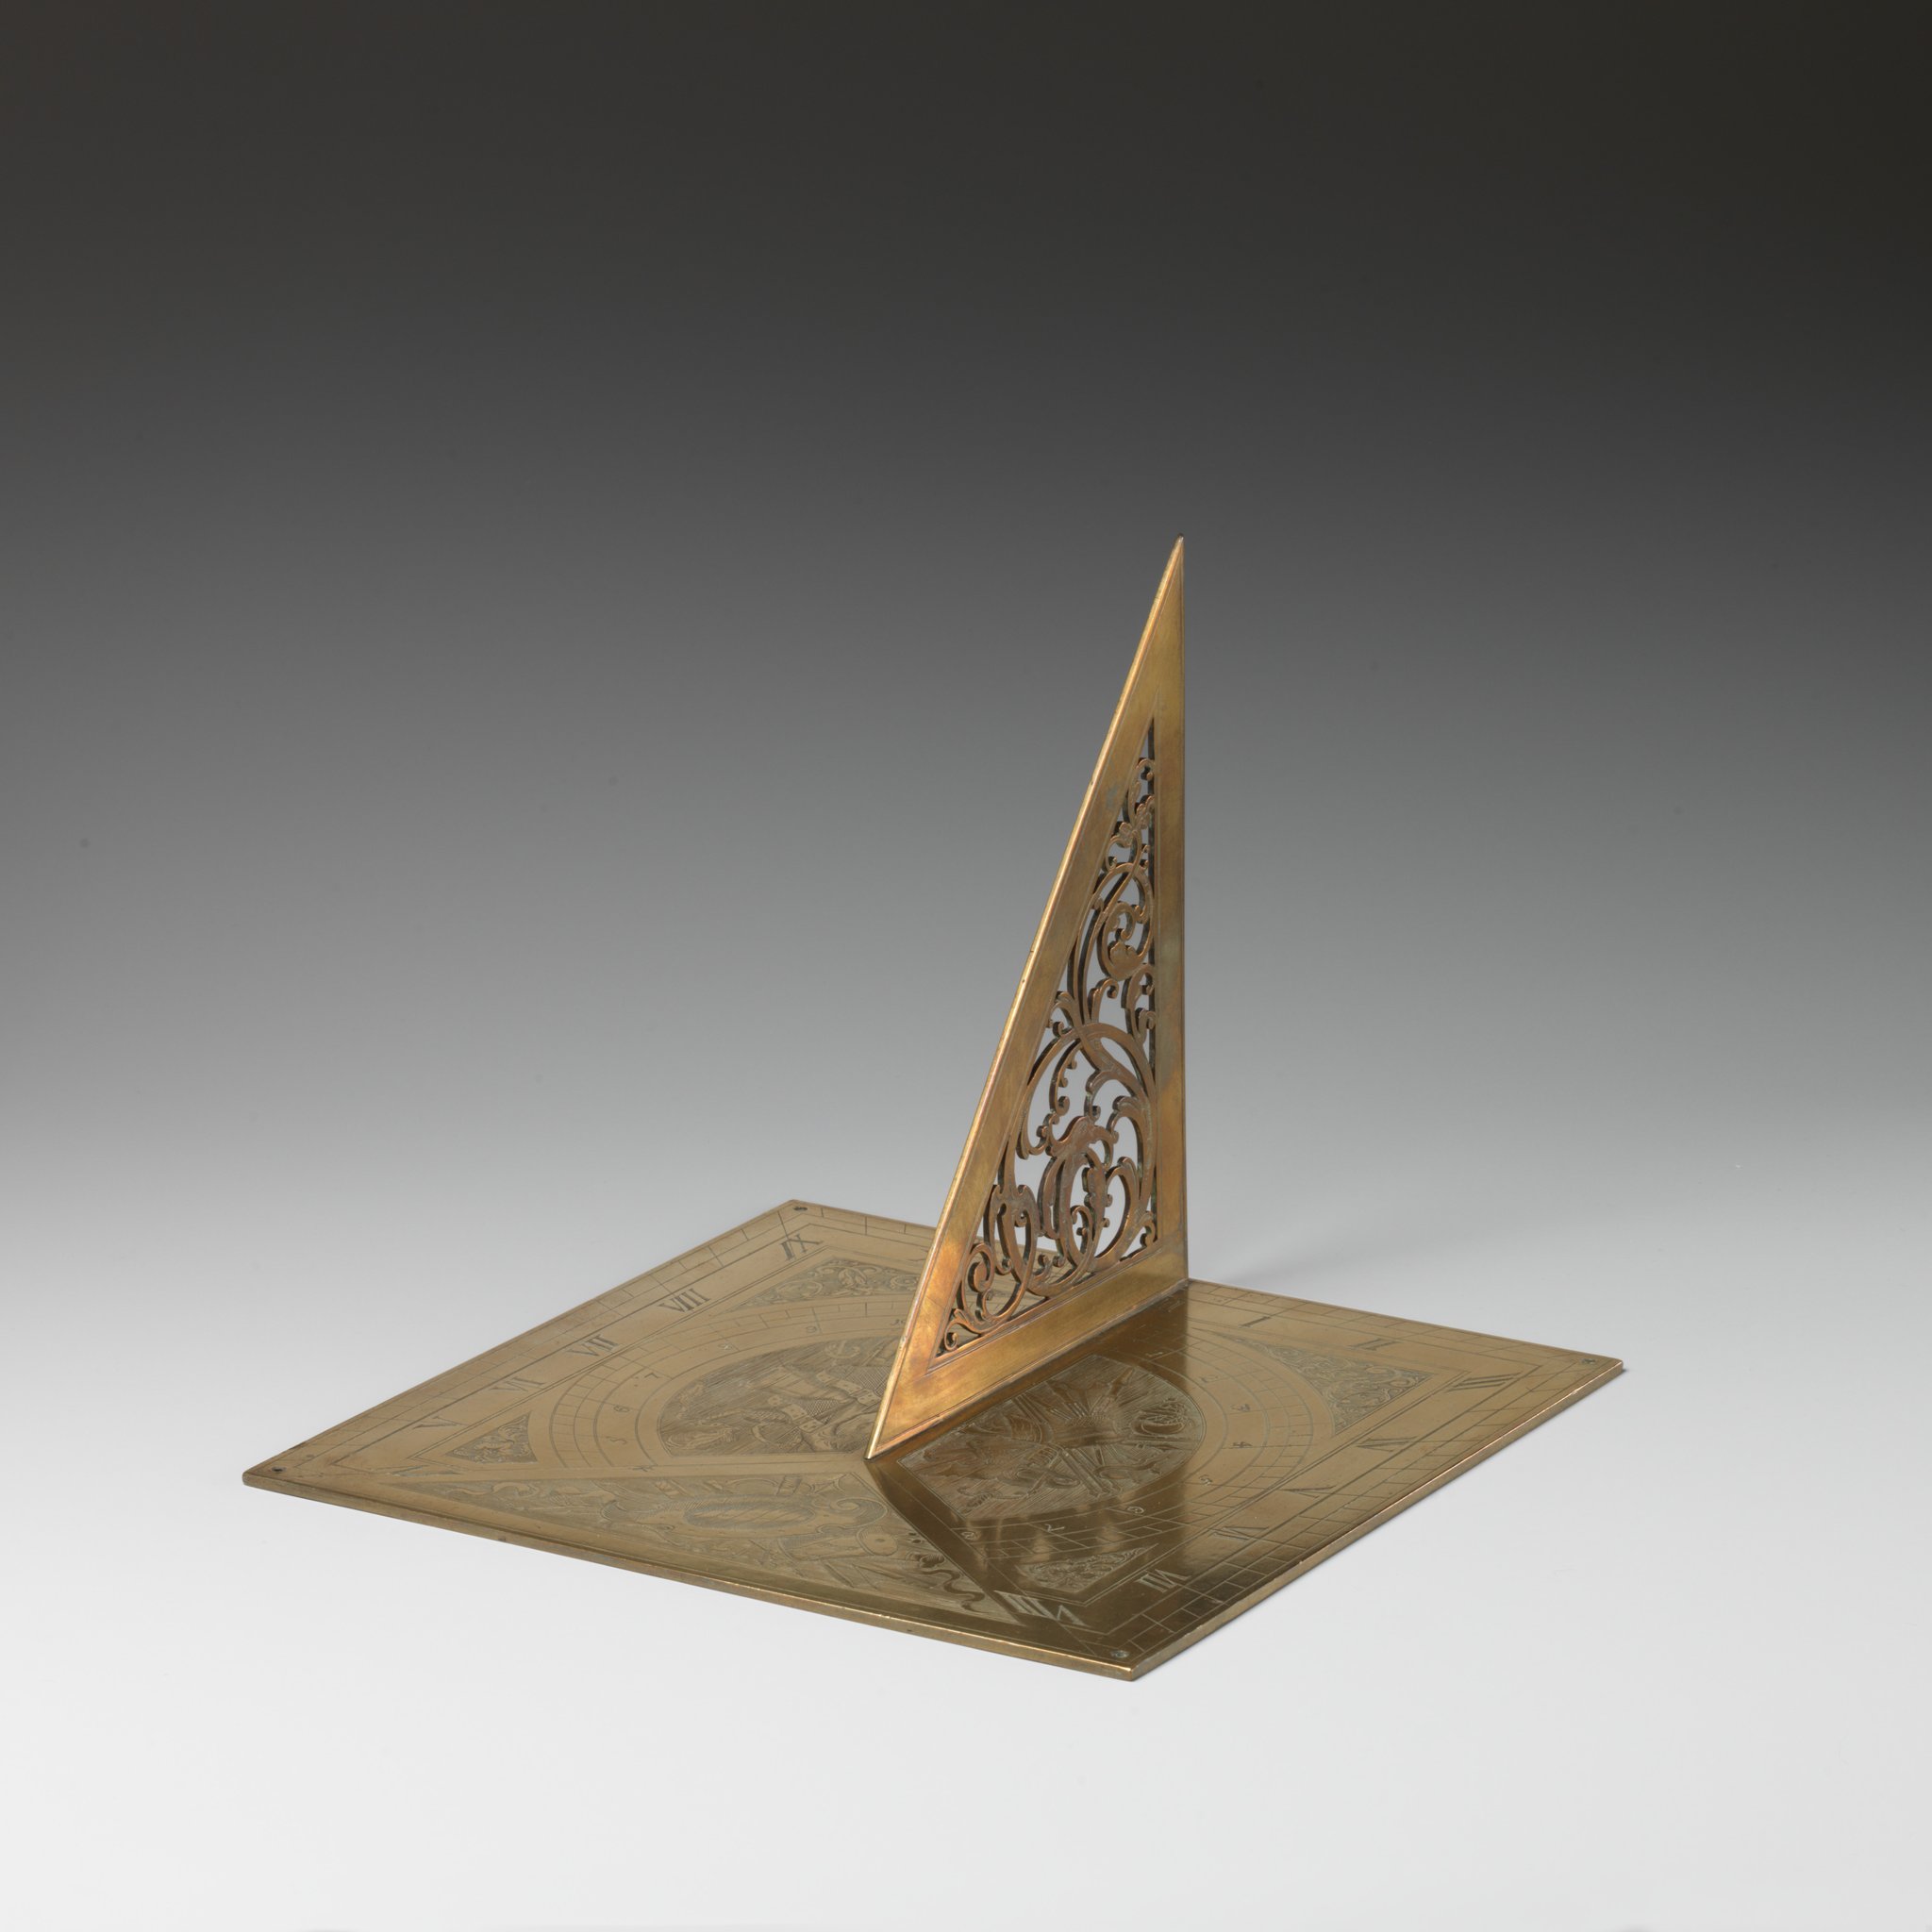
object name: stationary horizontal sundial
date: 1767-1800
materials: brass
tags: drums,sundials